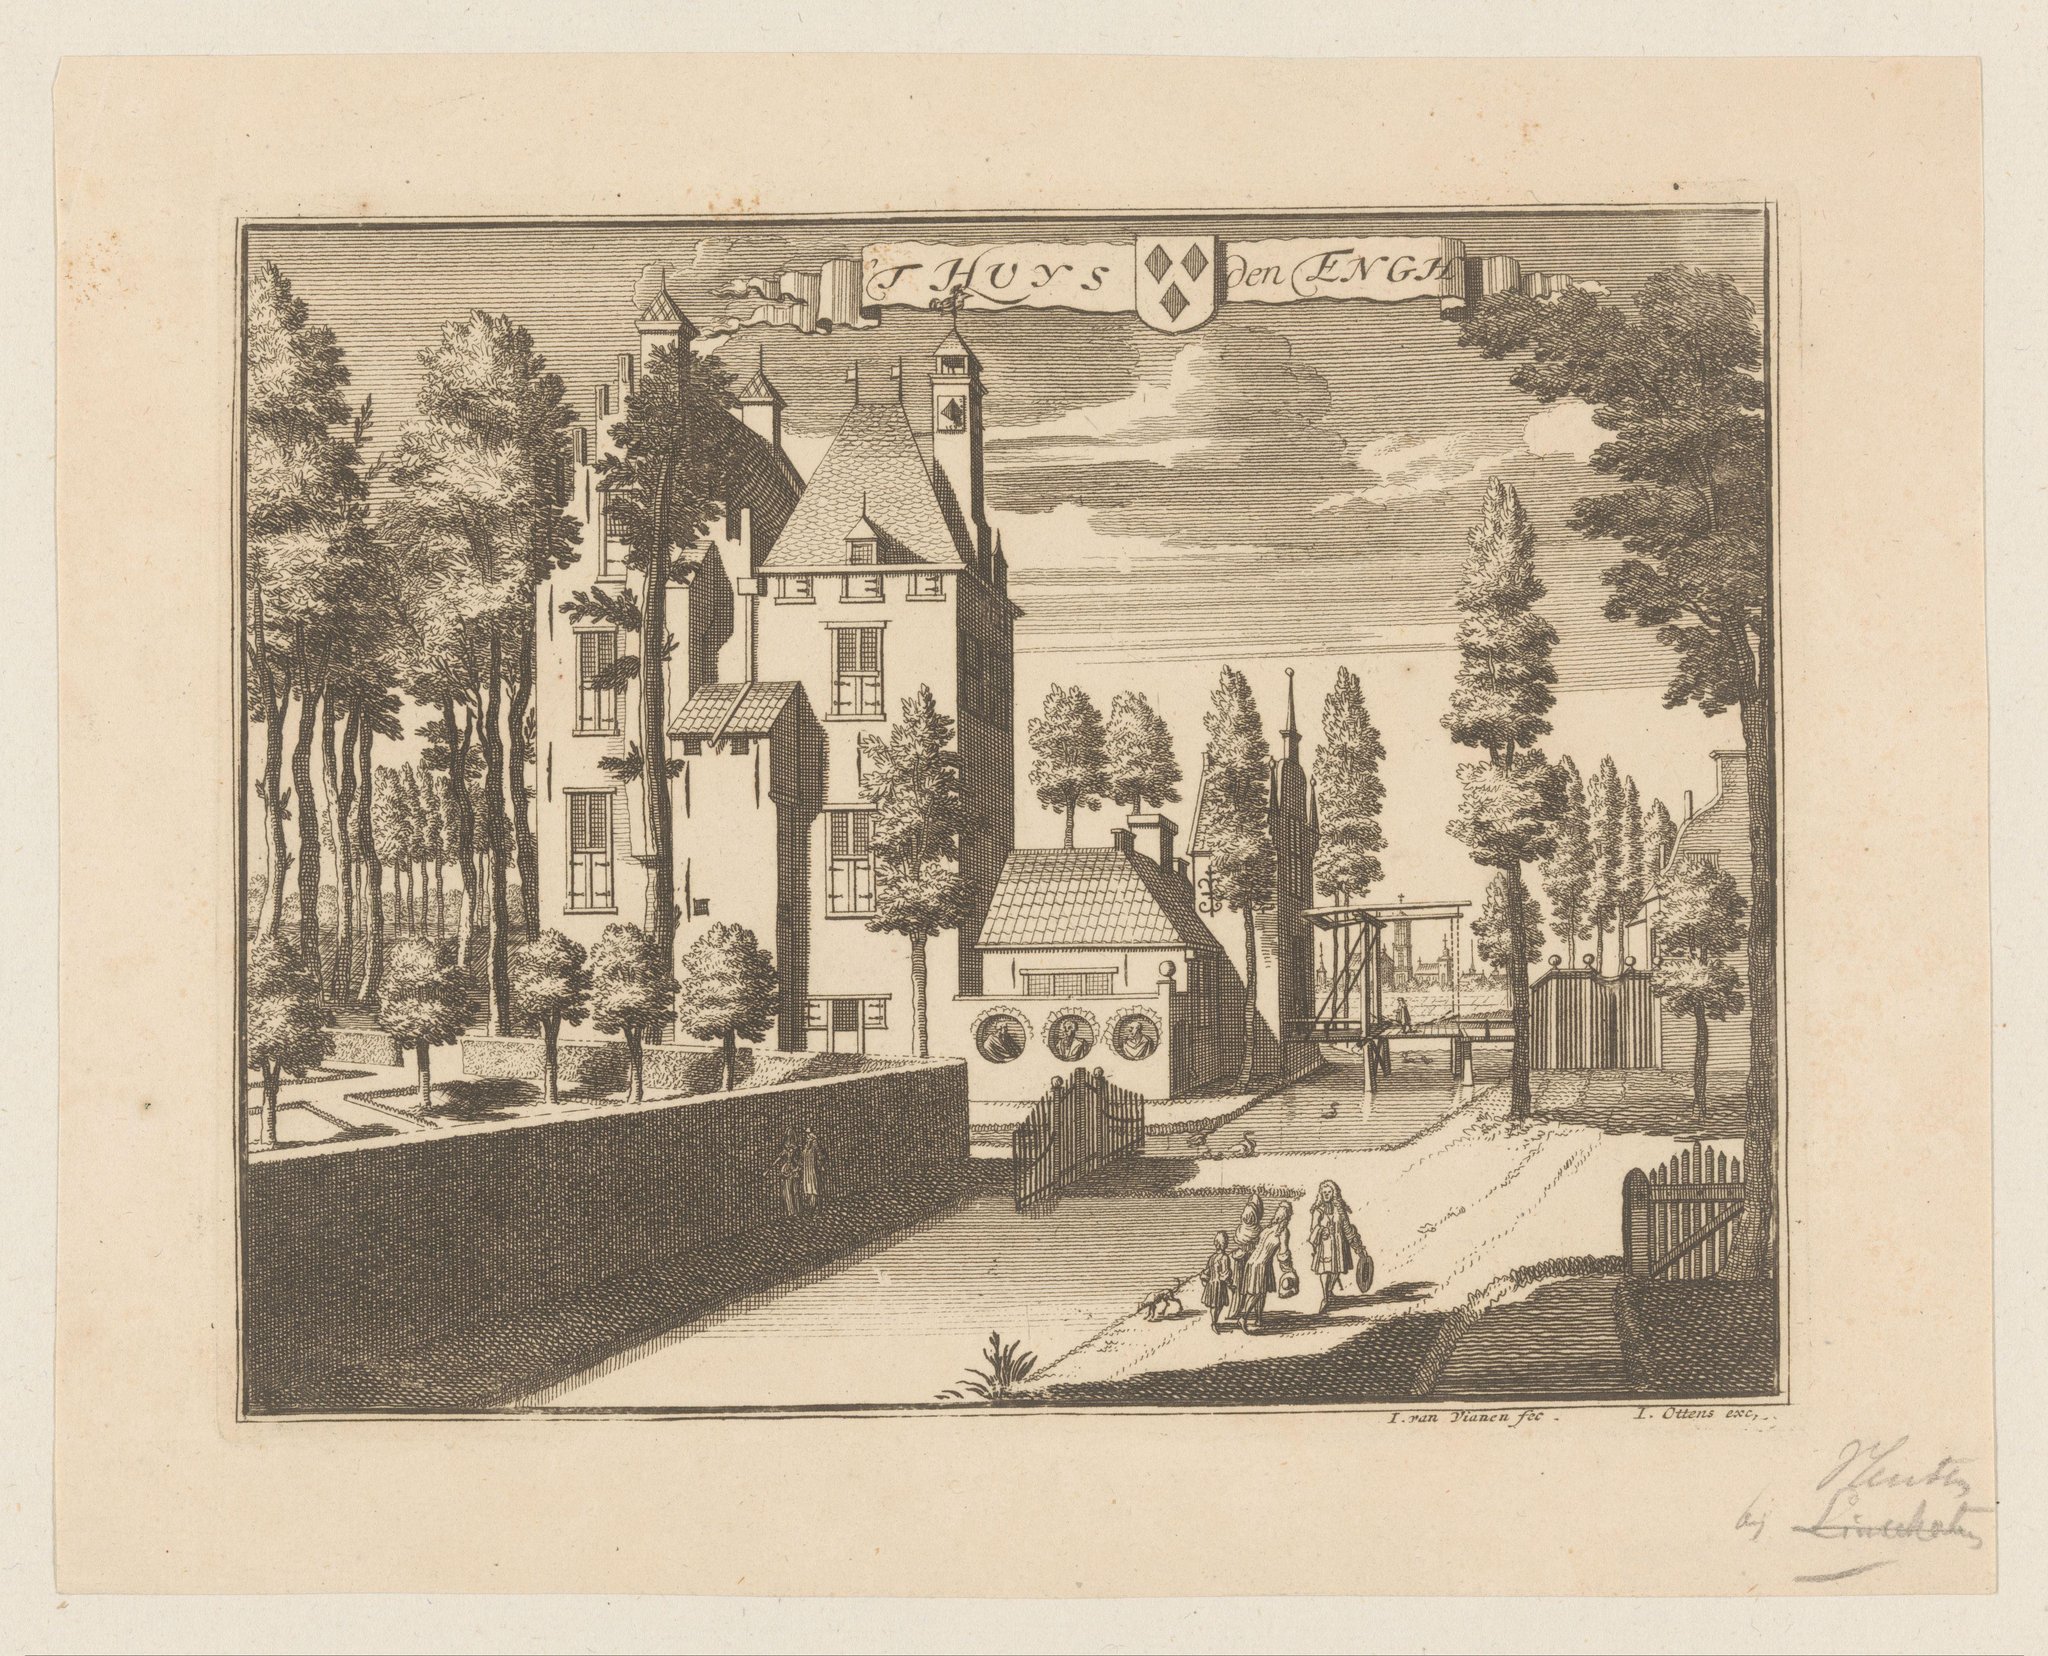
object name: print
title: 't Huys Den Engh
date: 1710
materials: paper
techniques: engraving, etching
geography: utrecht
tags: castle, landscape with tower or castle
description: Prent uit: De Ridder-matige Huysen en Gesichten in de Provincie van Utrecht. Amsterdam: Joachim Ottens, [ca. 1710].